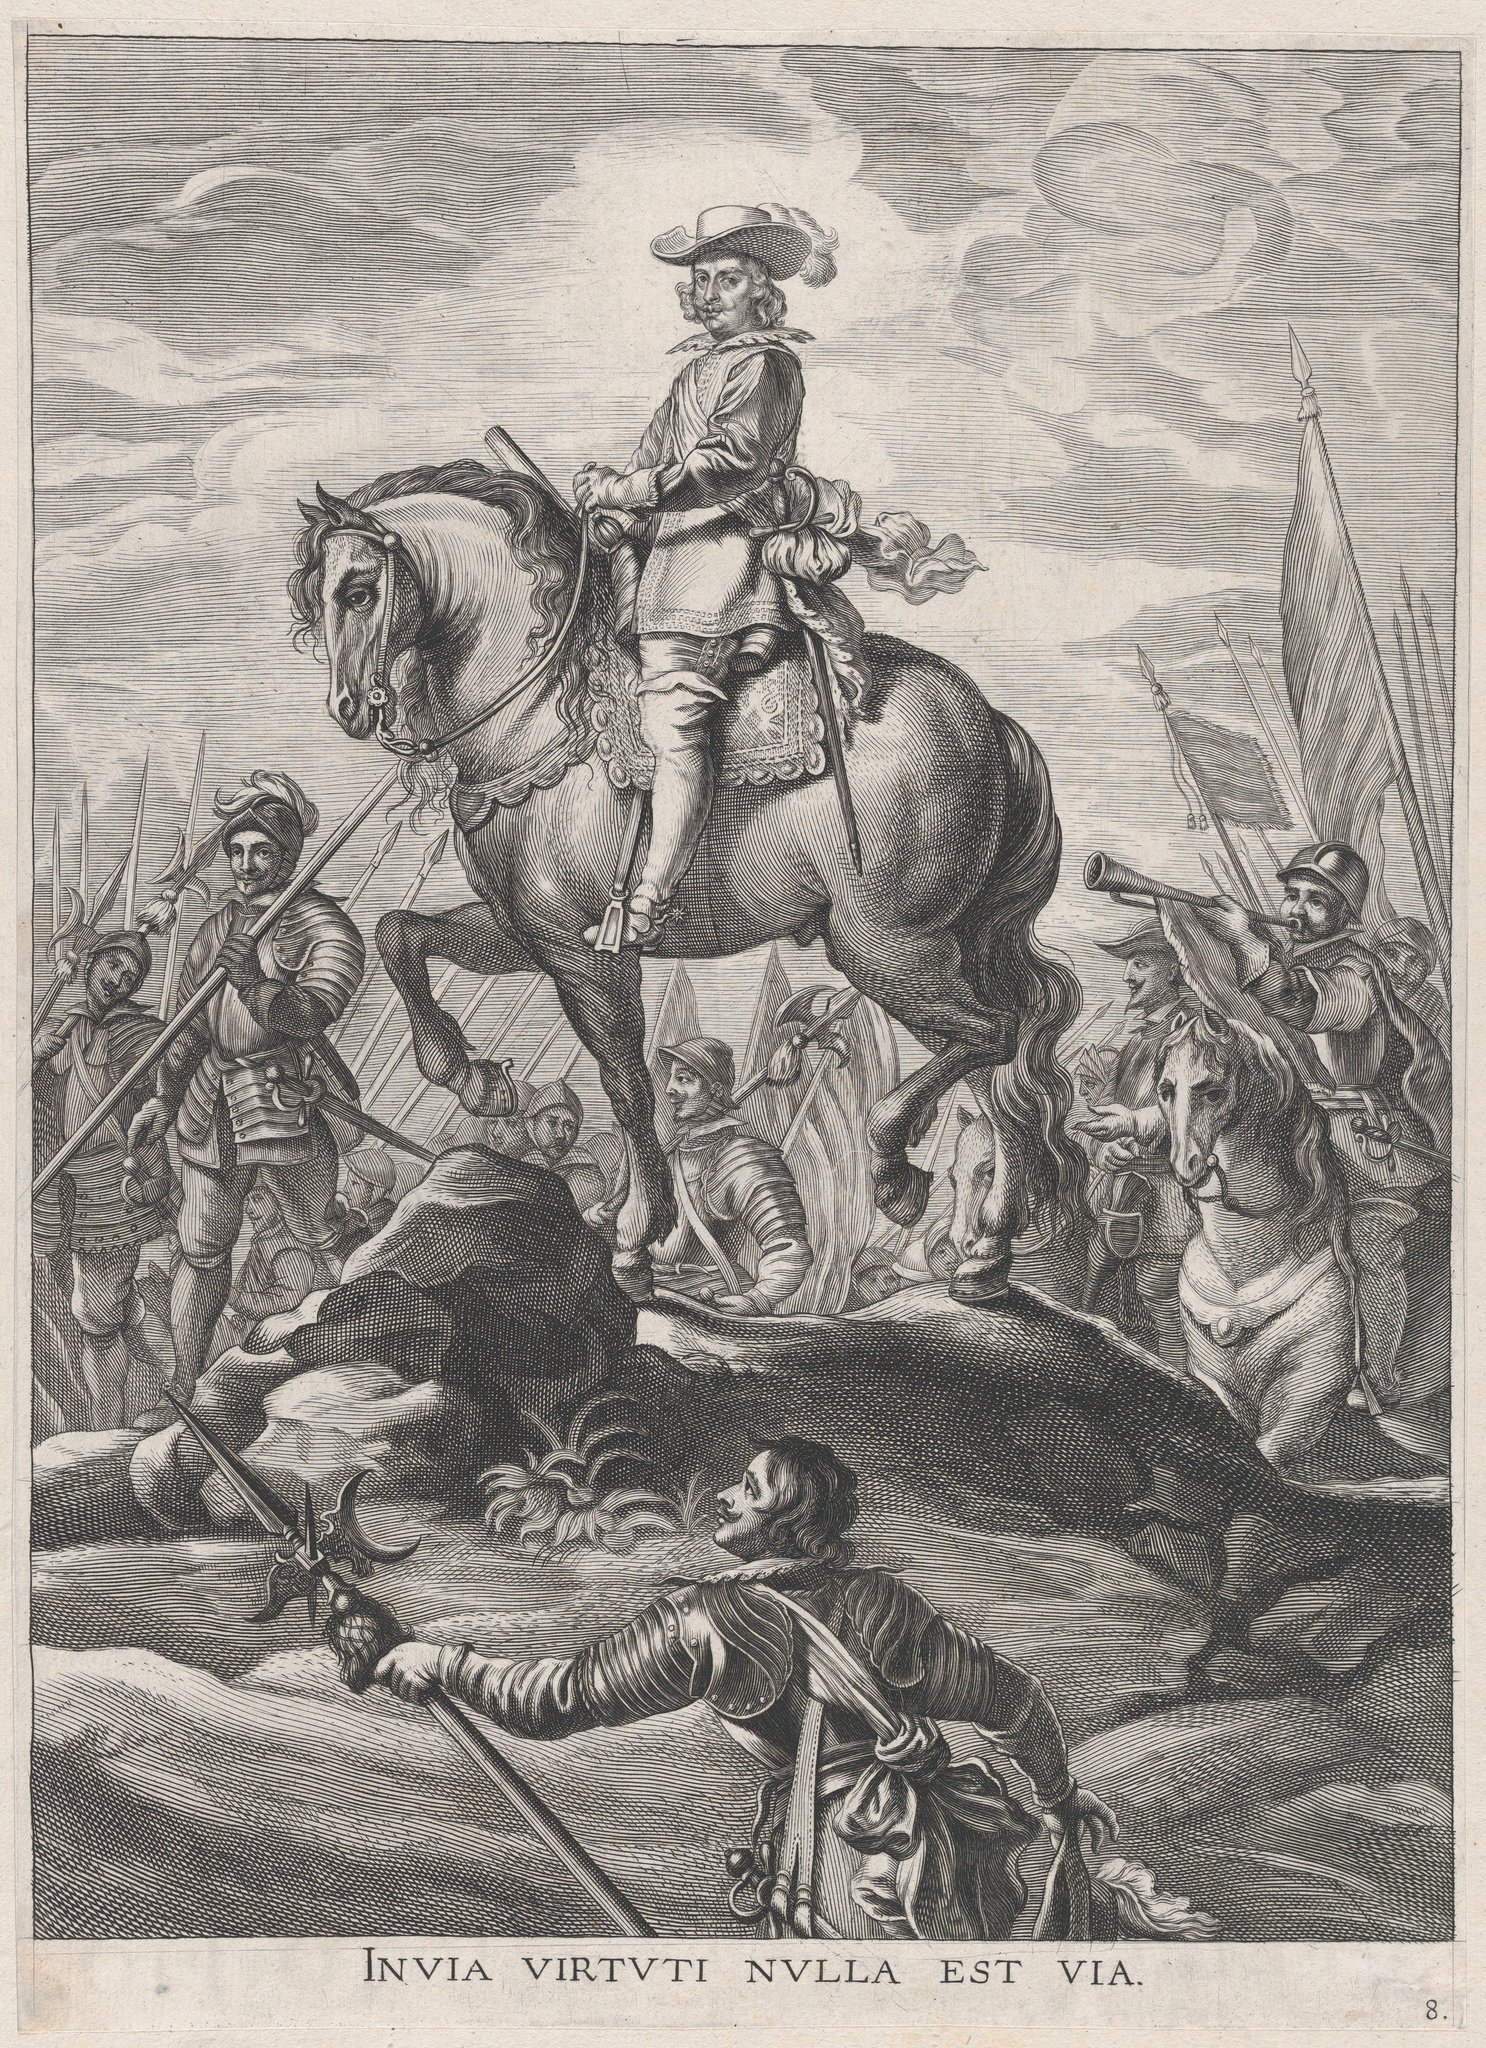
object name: print, fete, ornament architecture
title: Plate 8: Ferdinand on horseback crossing the Alps; from Guillielmus Becanus's 'Serenissimi Principis Ferdinandi, Hispaniarum Infantis...'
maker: pieter de jode (ii)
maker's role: artist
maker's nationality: flemish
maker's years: 1606-1674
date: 1636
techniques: engraving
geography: antwerp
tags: spears,men,horses